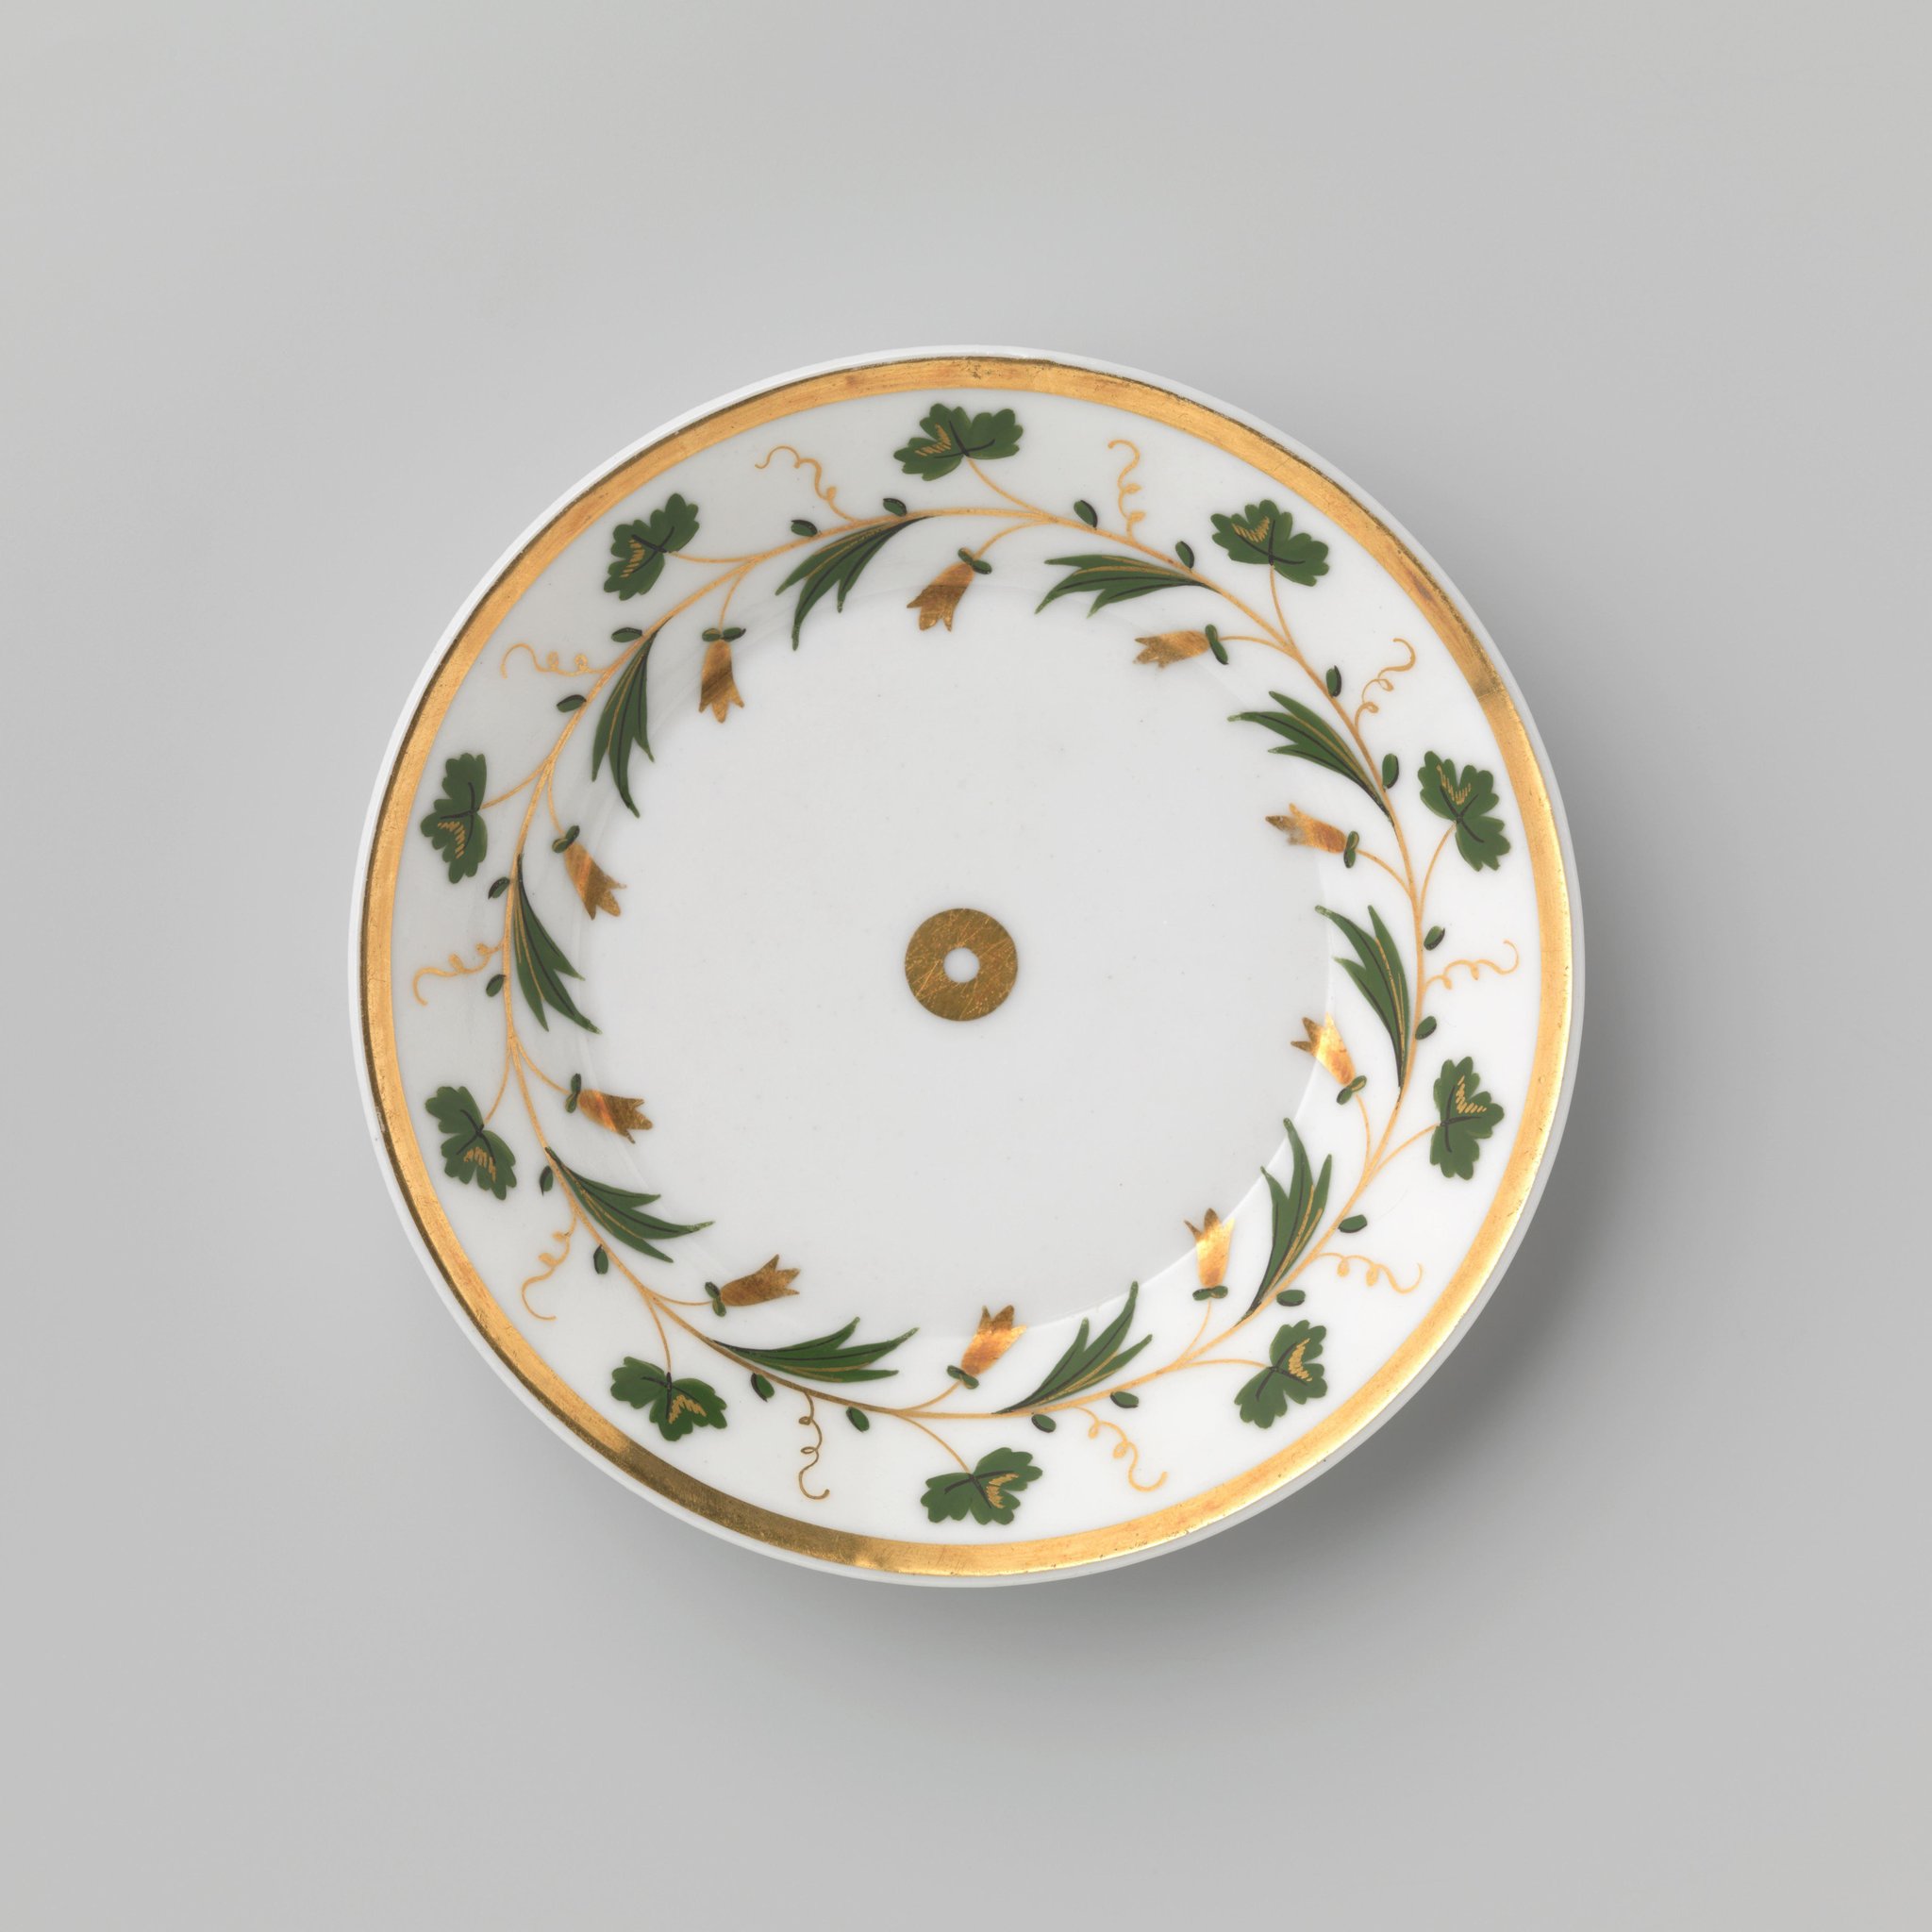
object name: platter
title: Saucer with a border of grapevines and flowers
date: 1800-1824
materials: glaze, gold, paint, porcelain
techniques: firing, forming, gilding, turning, vitrification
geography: paris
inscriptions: mark: ‘gekruiste pijlen’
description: Schotel van porselein met een rechte wand, beschilderd op het glazuur in groen, zwart en goud. In het centrum een gouden cirkel. Op de wand een band met aan de ene zijde wijnranken en aan de andere zijde bloemen en bladeren. Gouden rand. Gemerkt op de onderzijde met de gekruiste pijlen.